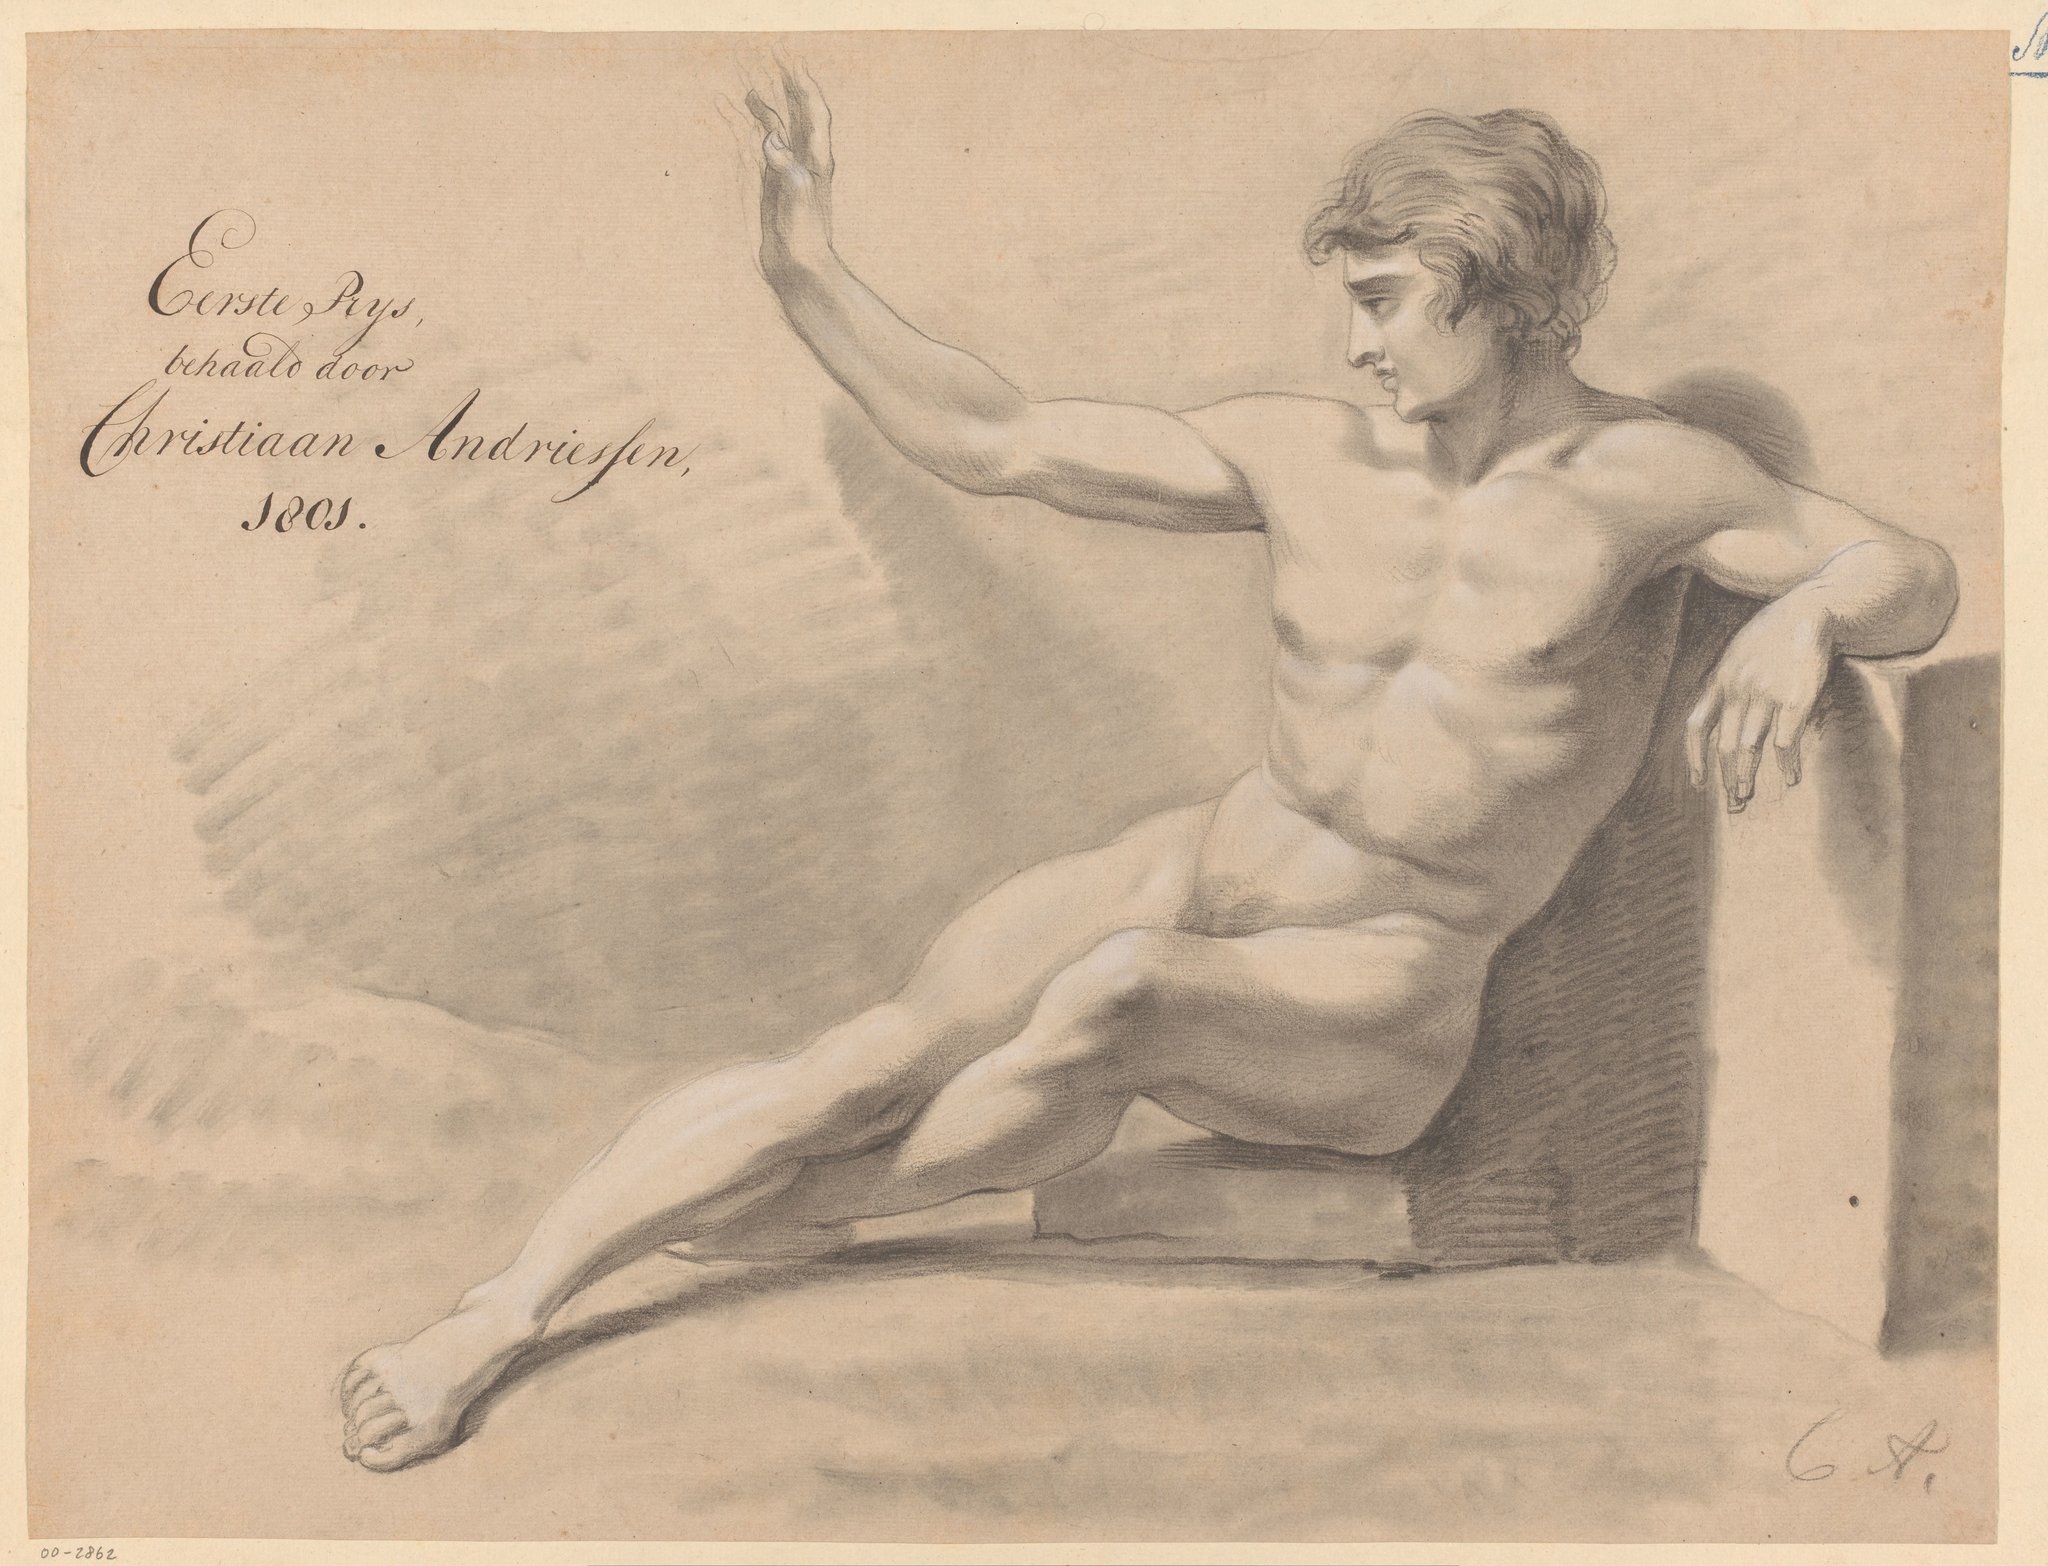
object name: drawing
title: Zittend mannelijk naakt, van voren gezien (1e prijs 1801)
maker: christiaan andriessen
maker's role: draughtsman, print maker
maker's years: 1775-1846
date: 1801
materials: chalk, paper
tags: sitting figure (+ nude human being)